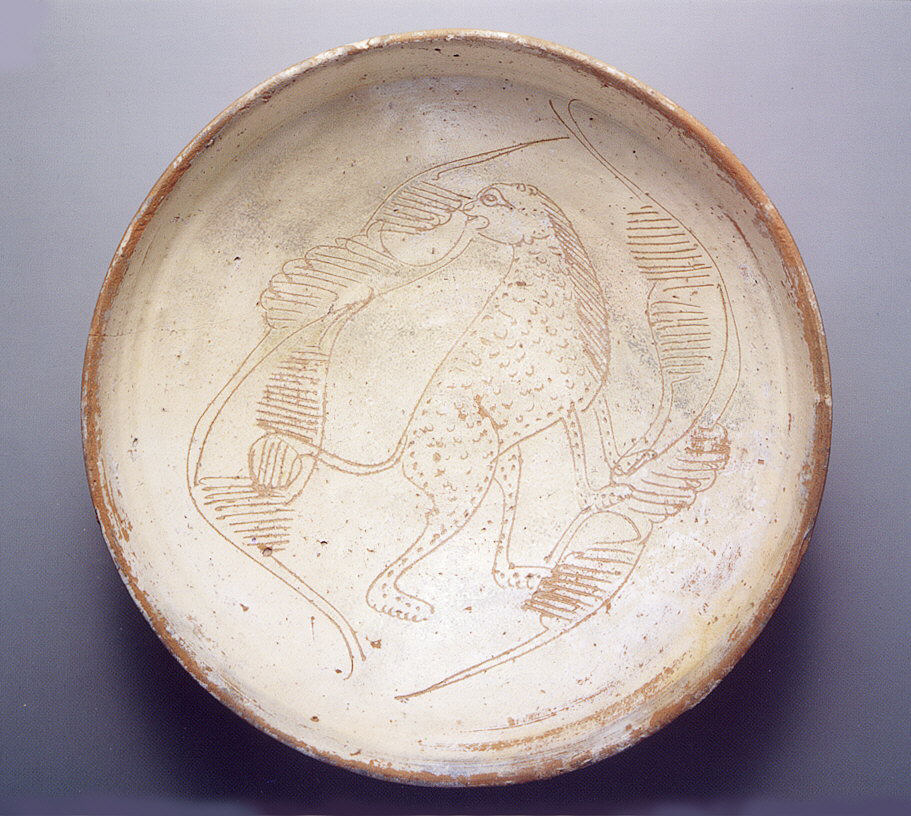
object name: bowl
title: Bowl with Cheetah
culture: byzantine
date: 1001-1300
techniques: engraving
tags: cheetahs